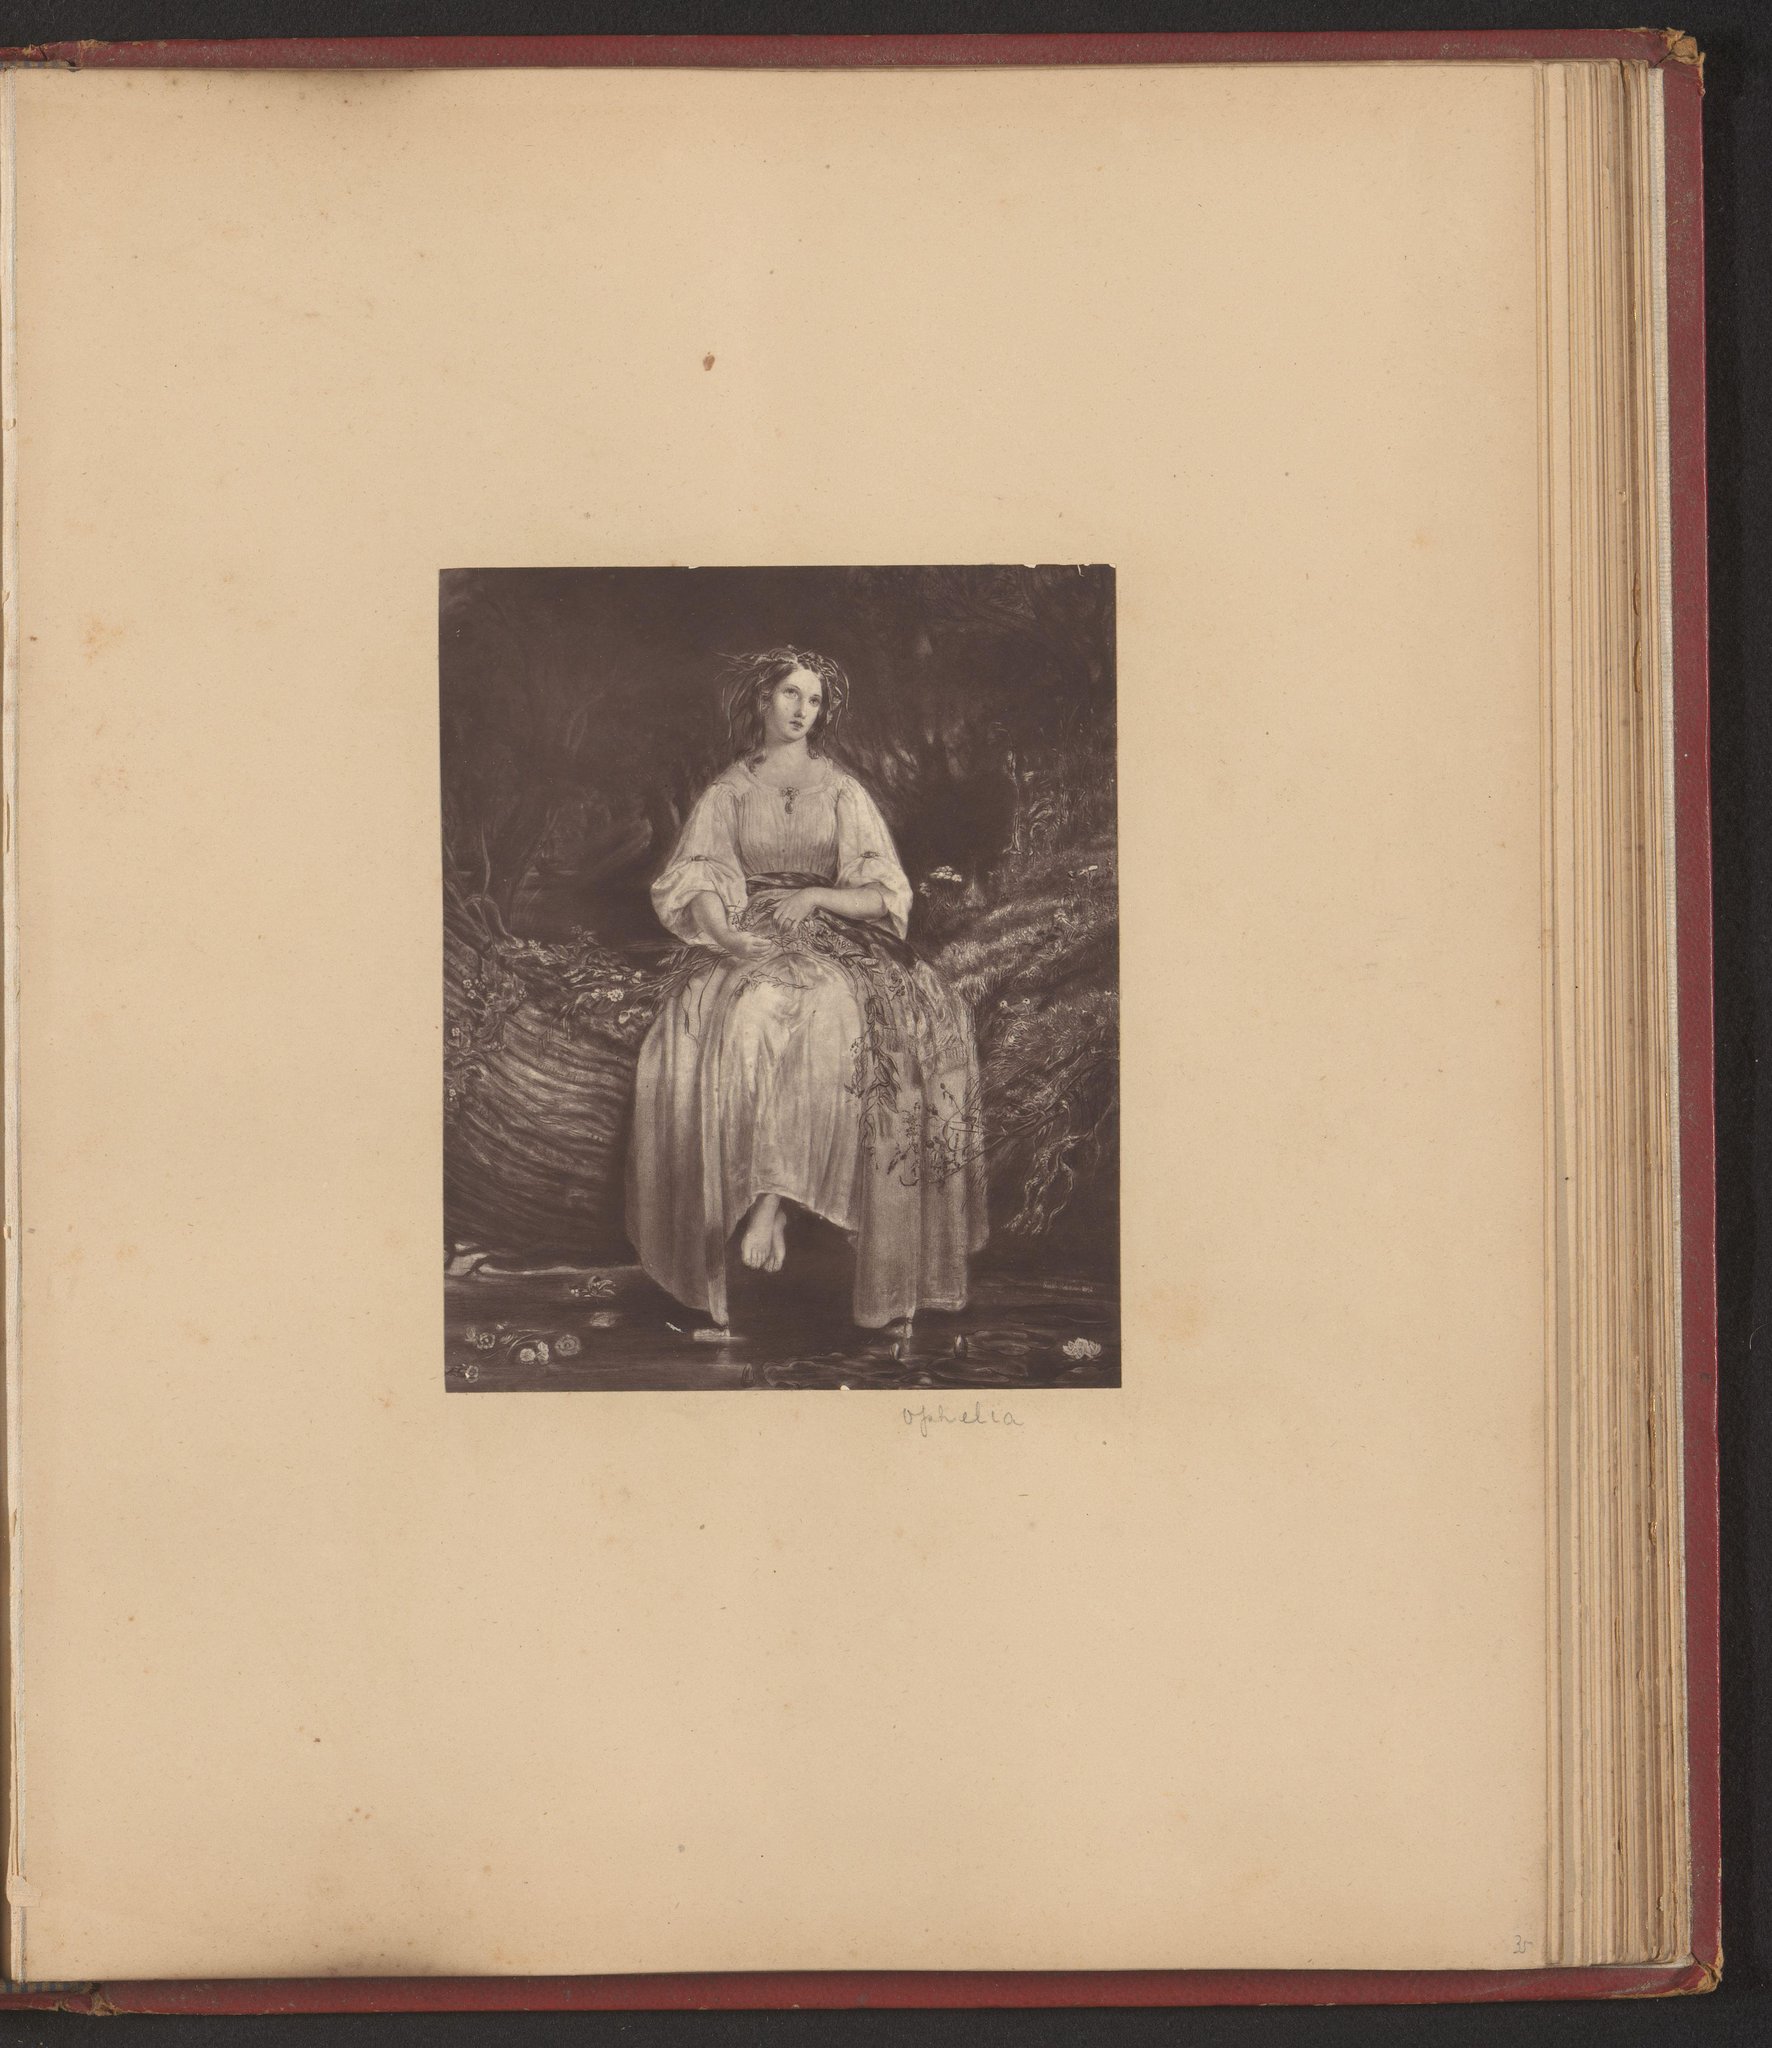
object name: reproduction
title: Fotoreproductie van een schilderij met Ophelia op een boomstronk boven het water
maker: Anonymous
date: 1875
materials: photographic support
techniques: woodburytype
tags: ophelia